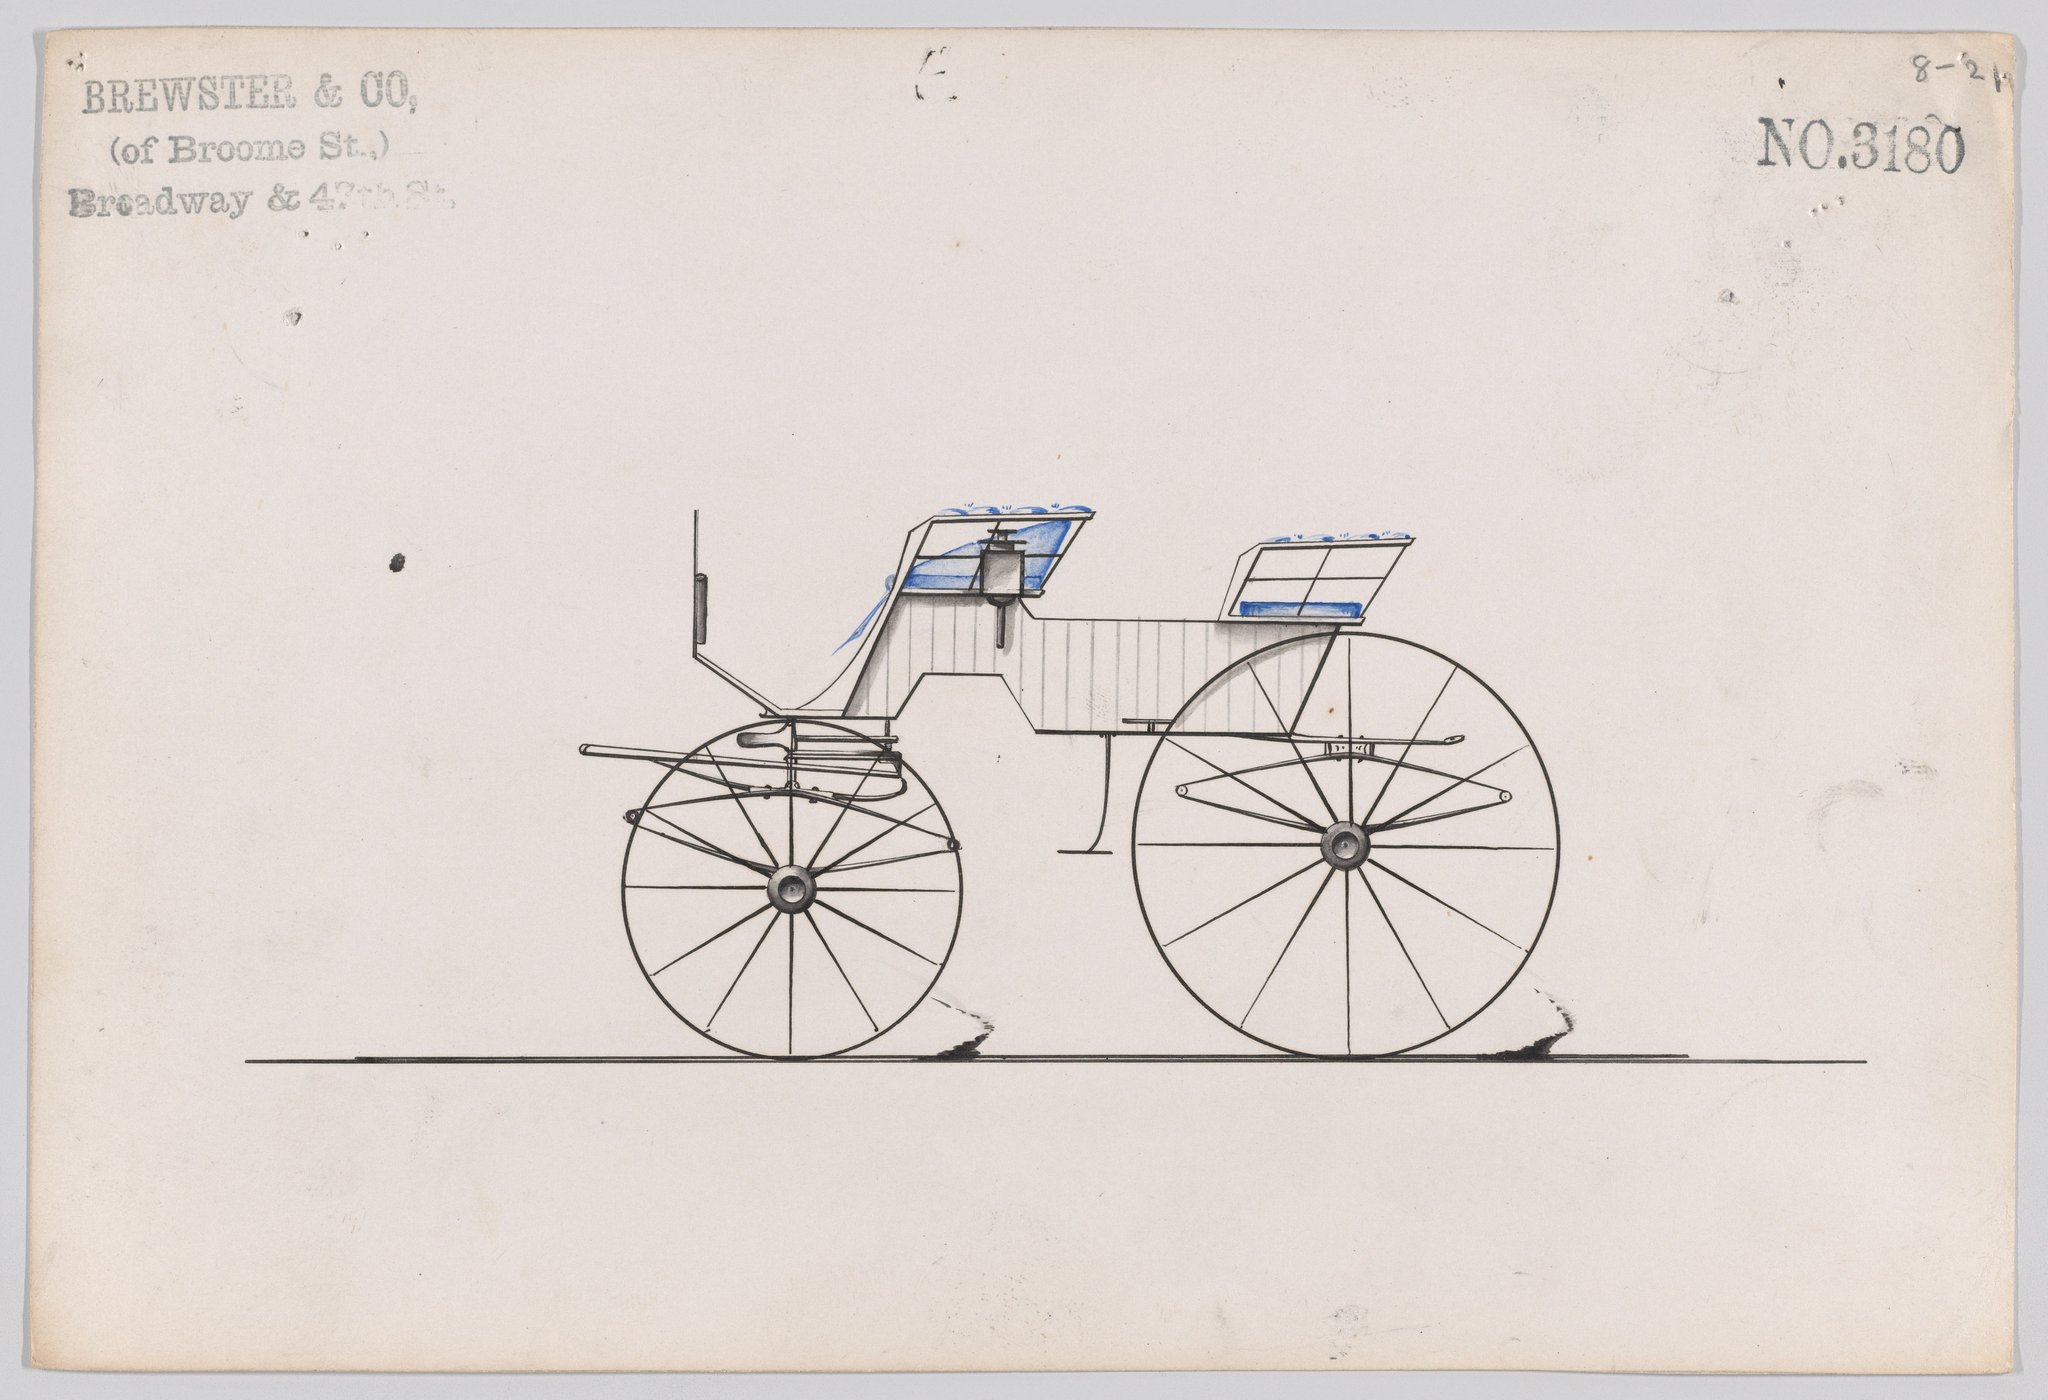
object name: drawing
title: Design for 4 seat Phaeton, no top, no. 3180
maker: brewster & co.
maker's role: manufacturer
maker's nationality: american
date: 1876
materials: gouache, watercolor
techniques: pen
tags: carriages